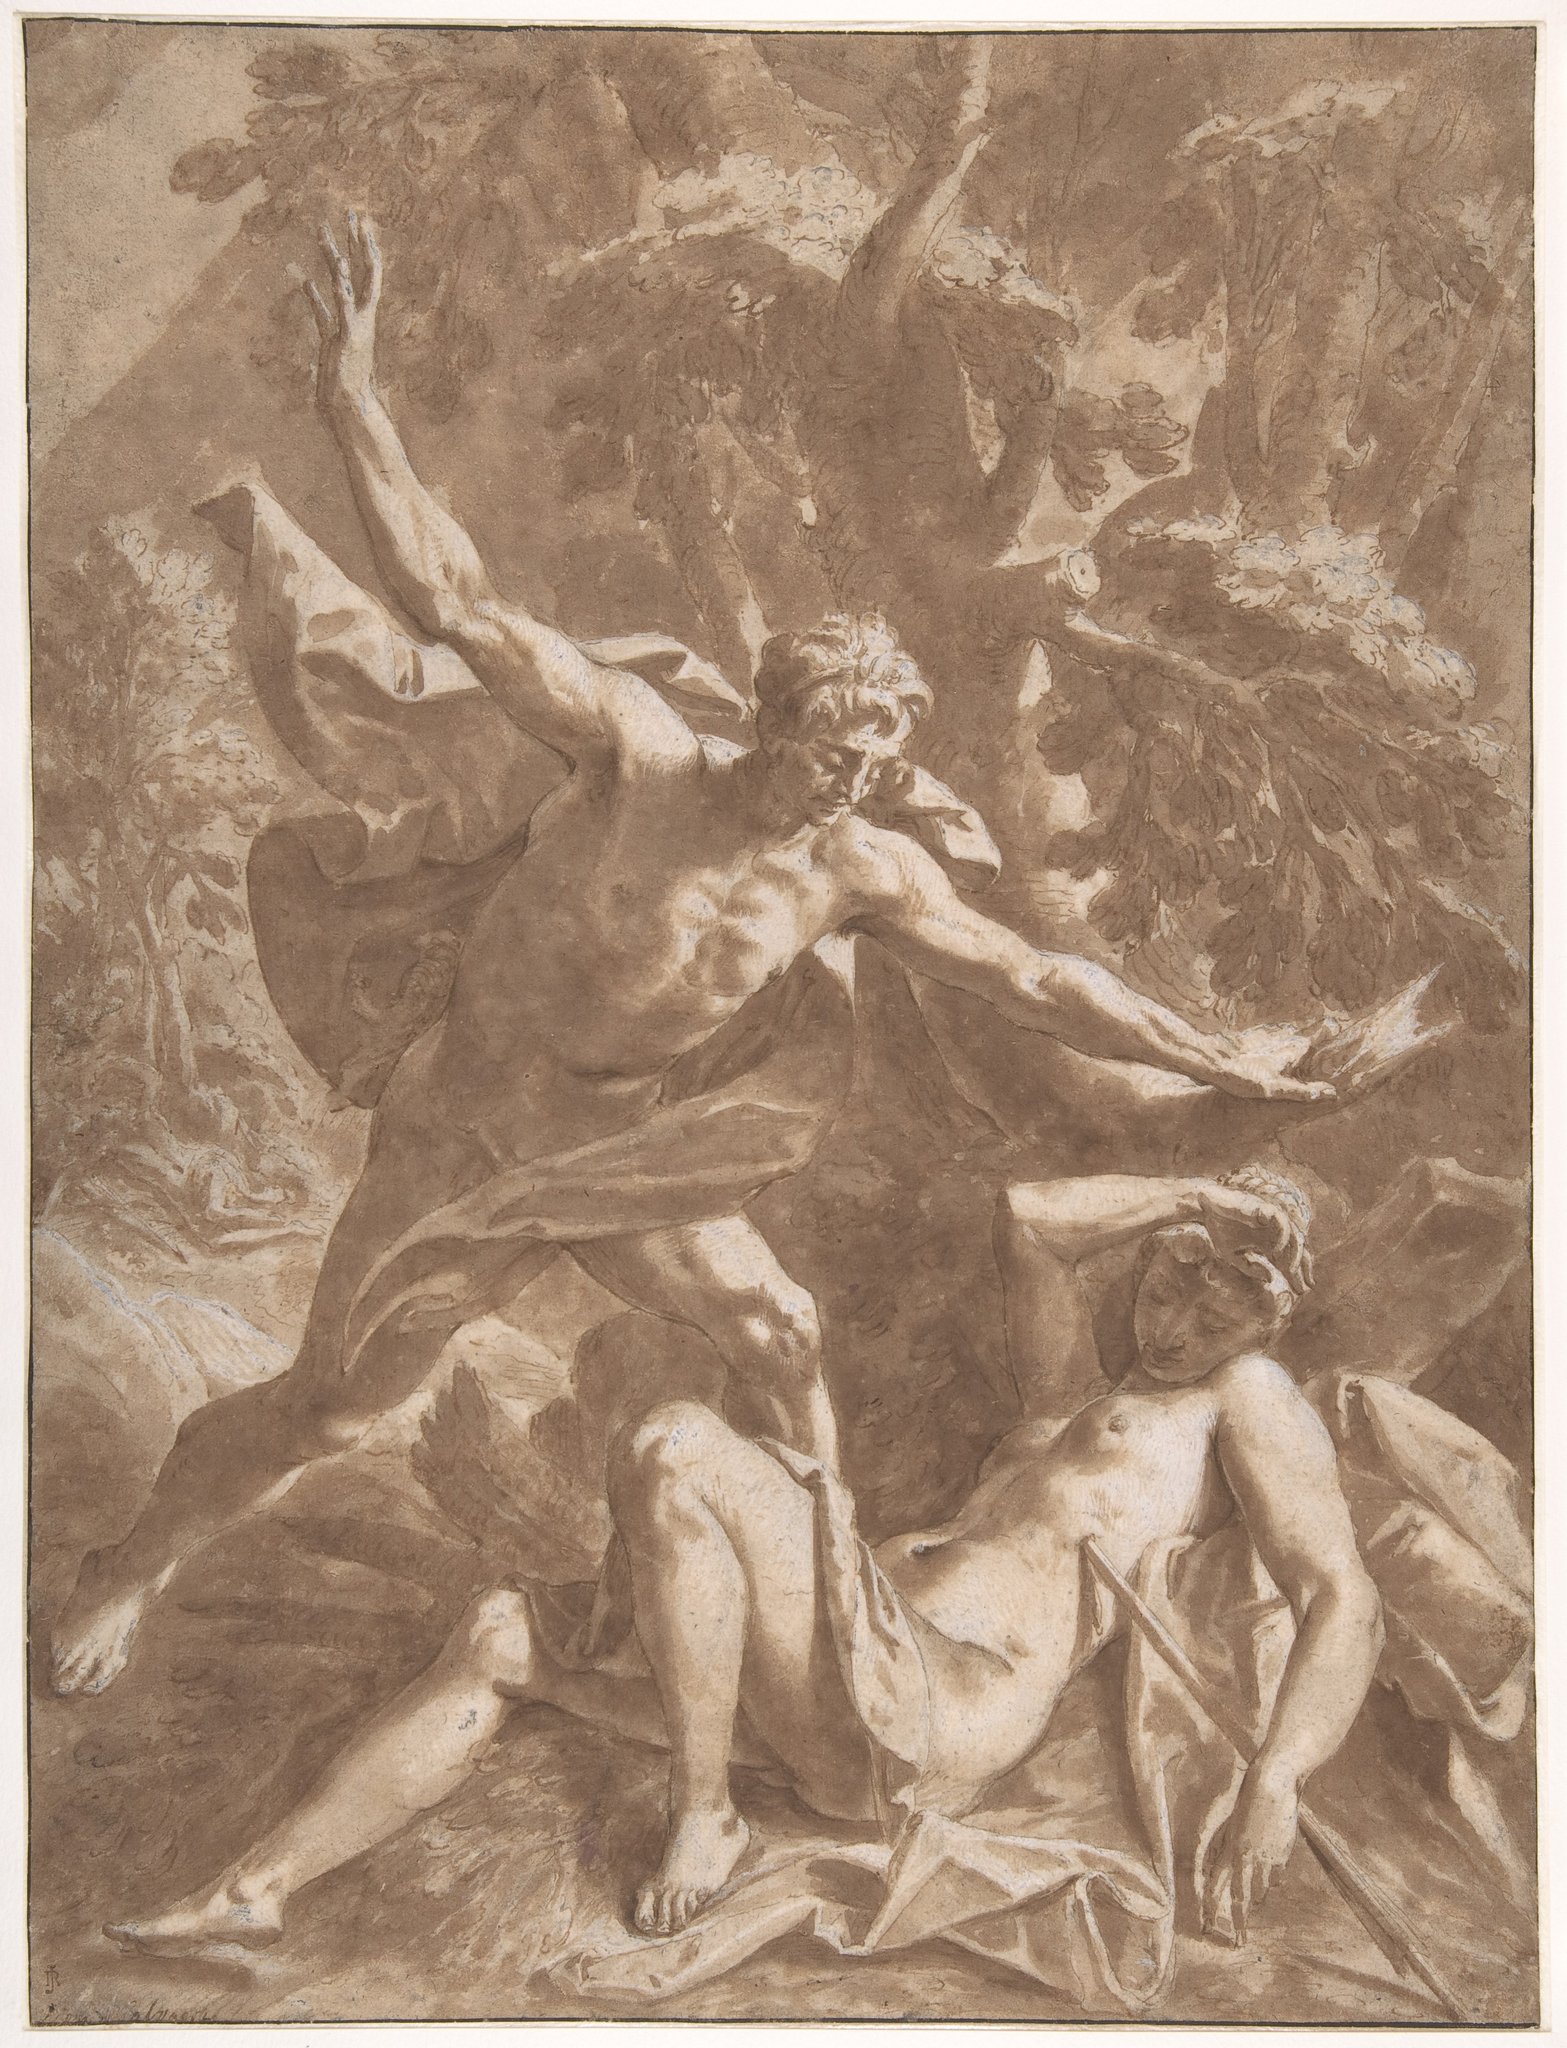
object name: drawing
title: Cephalus and Procris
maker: anonymous, netherlandish, 16th century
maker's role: artist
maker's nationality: netherlandish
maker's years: 1500-1600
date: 1501-1600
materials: chalk, ink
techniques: brush, heightening, pen, wash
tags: male nudes,female nudes